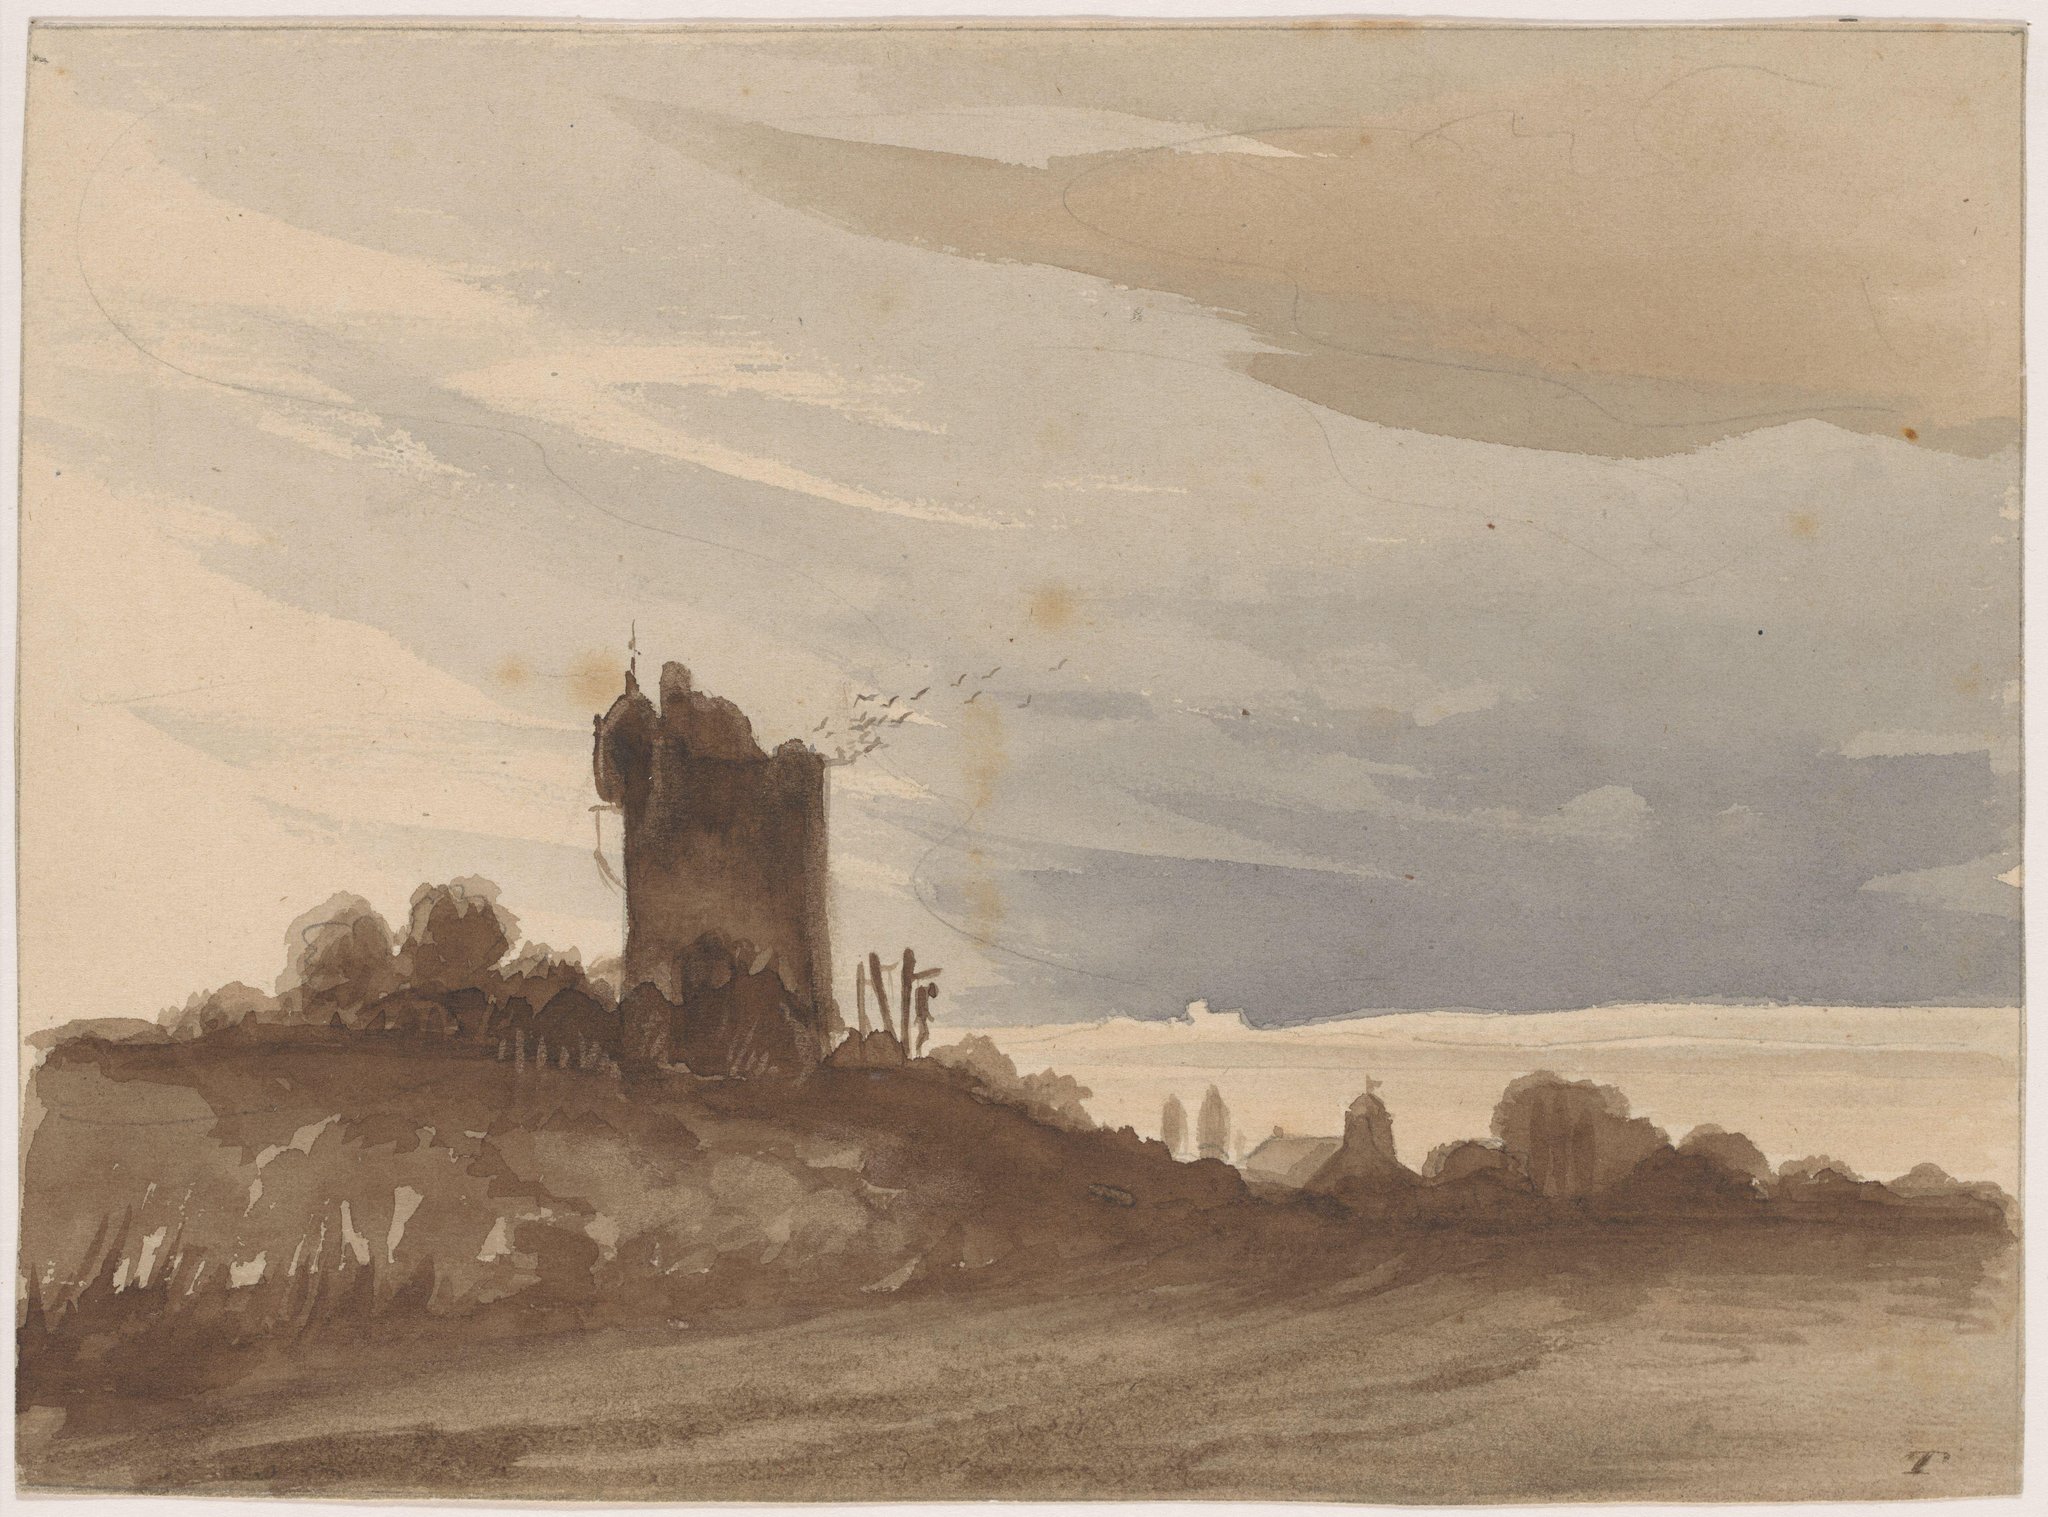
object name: drawing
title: Landschap met vervallen toren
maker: johannes tavenraat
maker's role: draughtsman, painter, print maker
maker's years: 1809-1881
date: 1840-1880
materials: ink, paper, watercolor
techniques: brush, pen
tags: landscape with ruins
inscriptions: collector's mark: Lugt 2228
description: Landschap met weg langs een vervallen toren, in de verte een dorp.